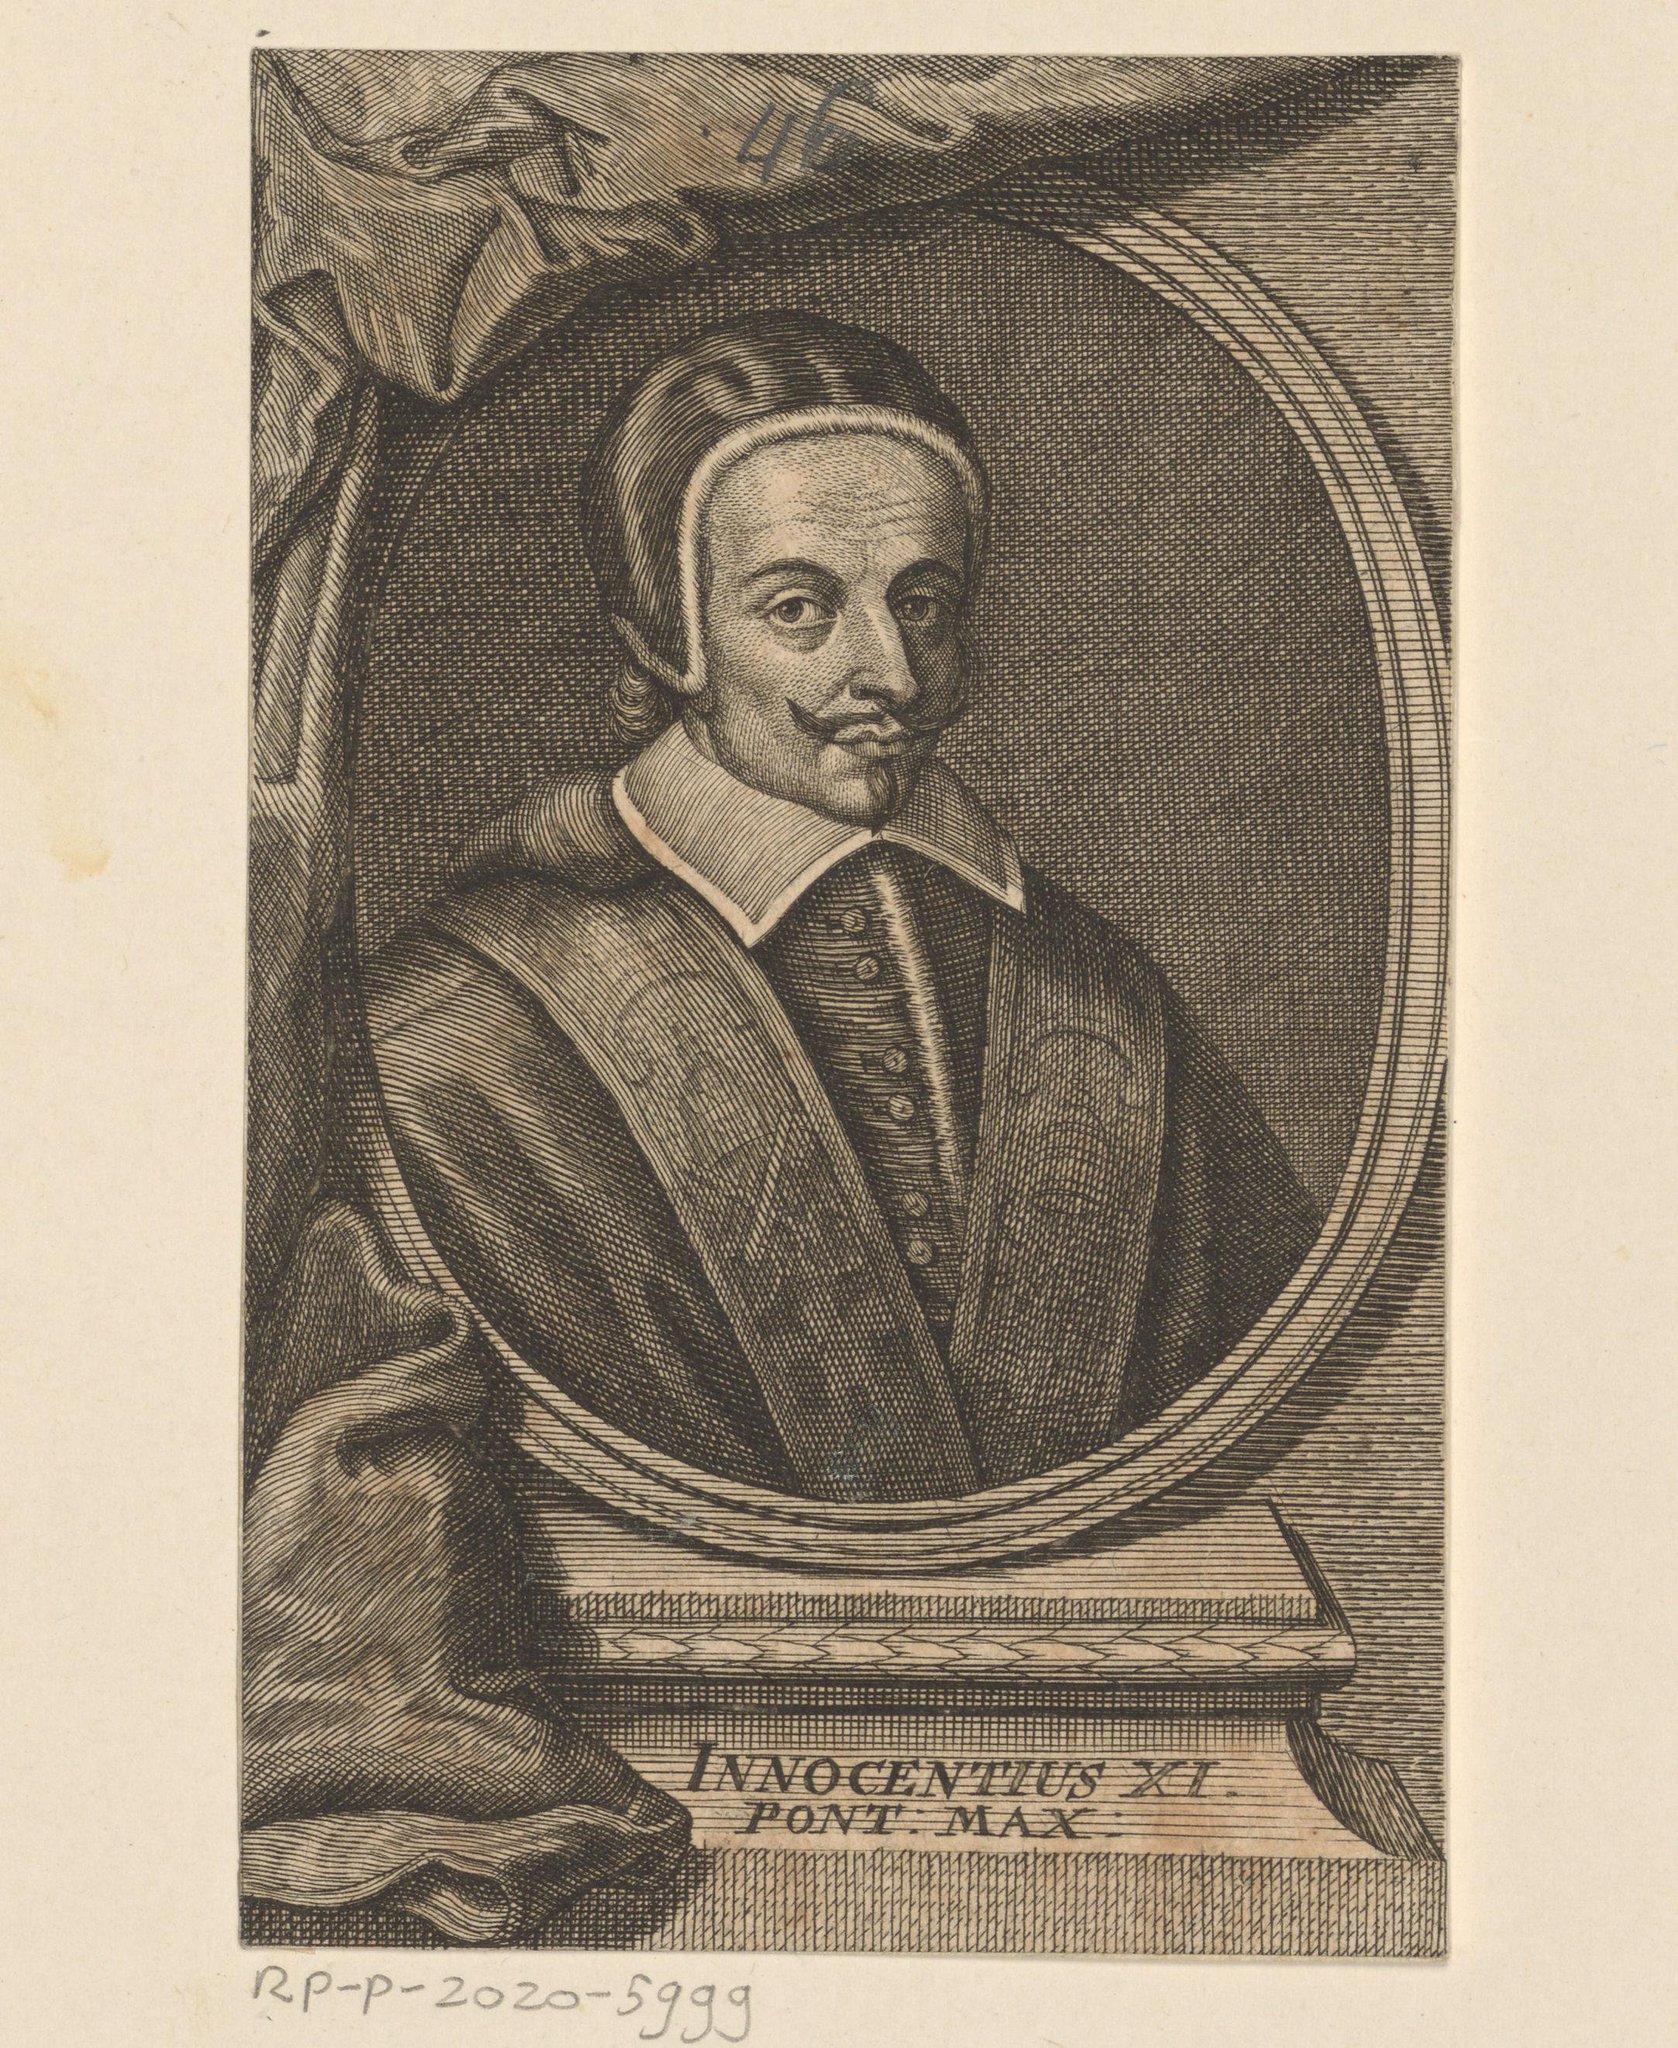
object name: print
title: Portret van paus Innocentius XI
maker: johann georg mentzel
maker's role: print maker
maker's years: 1677-1743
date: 1687-1743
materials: paper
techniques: engraving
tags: rome, clergyman, innocentius xi, historical persons, pope